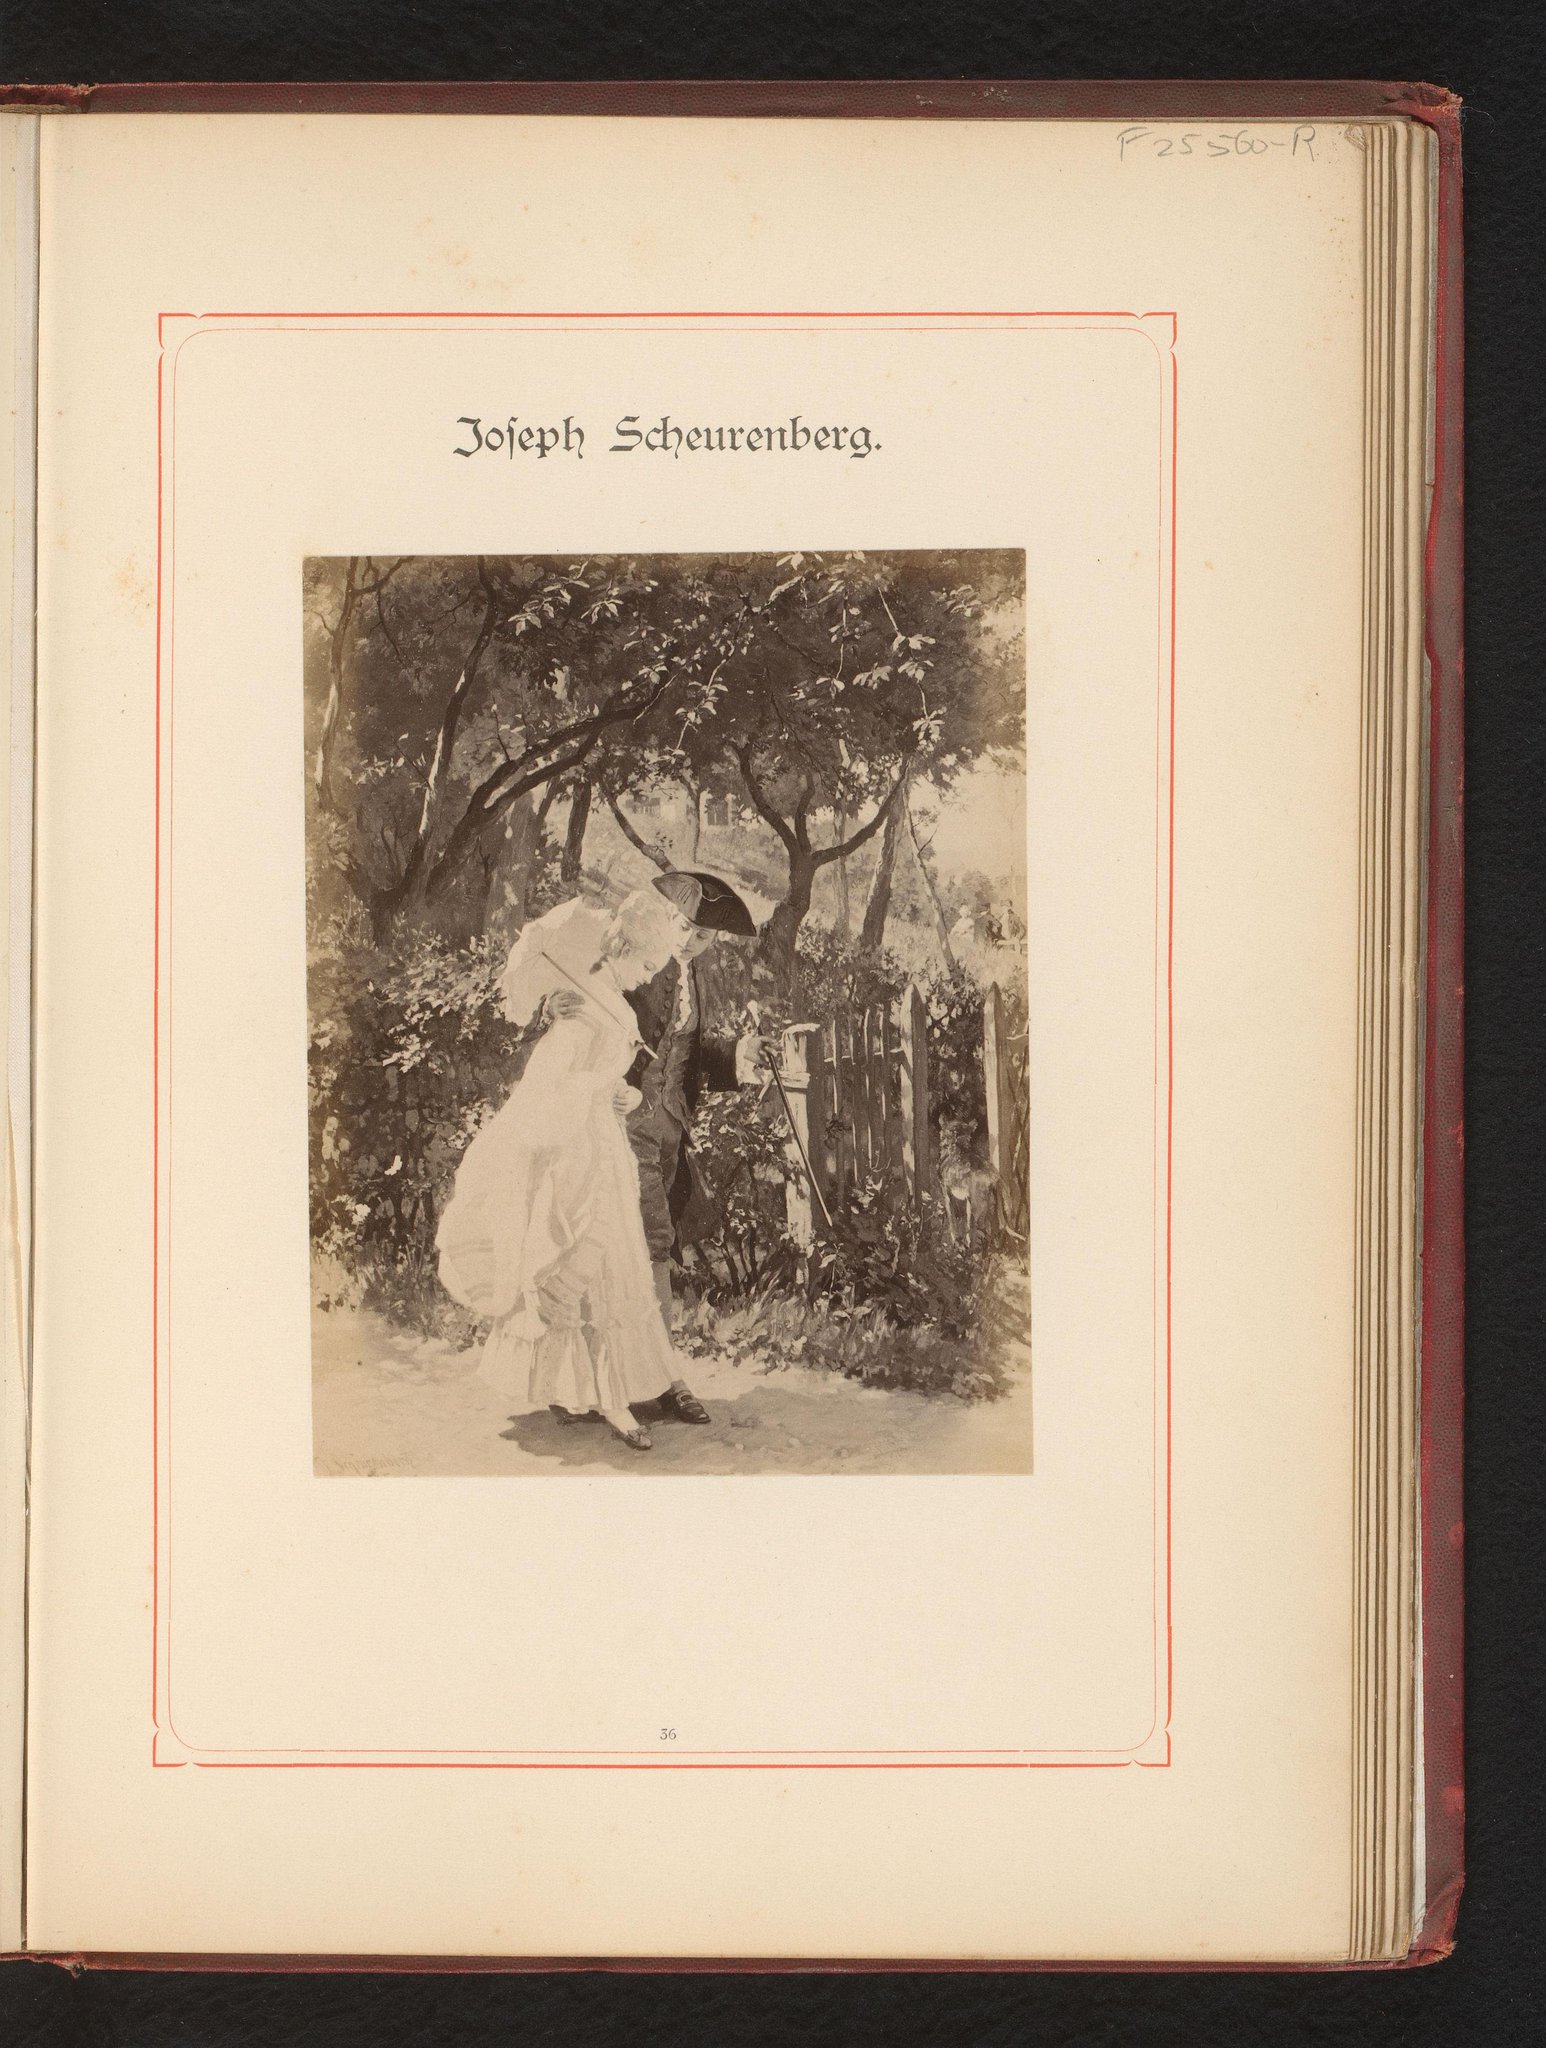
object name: photograph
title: Fotoreproductie van een schilderij van een paar wandelend door een tuin door Josef Scheurenberg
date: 1870-1890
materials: paper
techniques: albumen print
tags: lovers' meeting, picture, painting